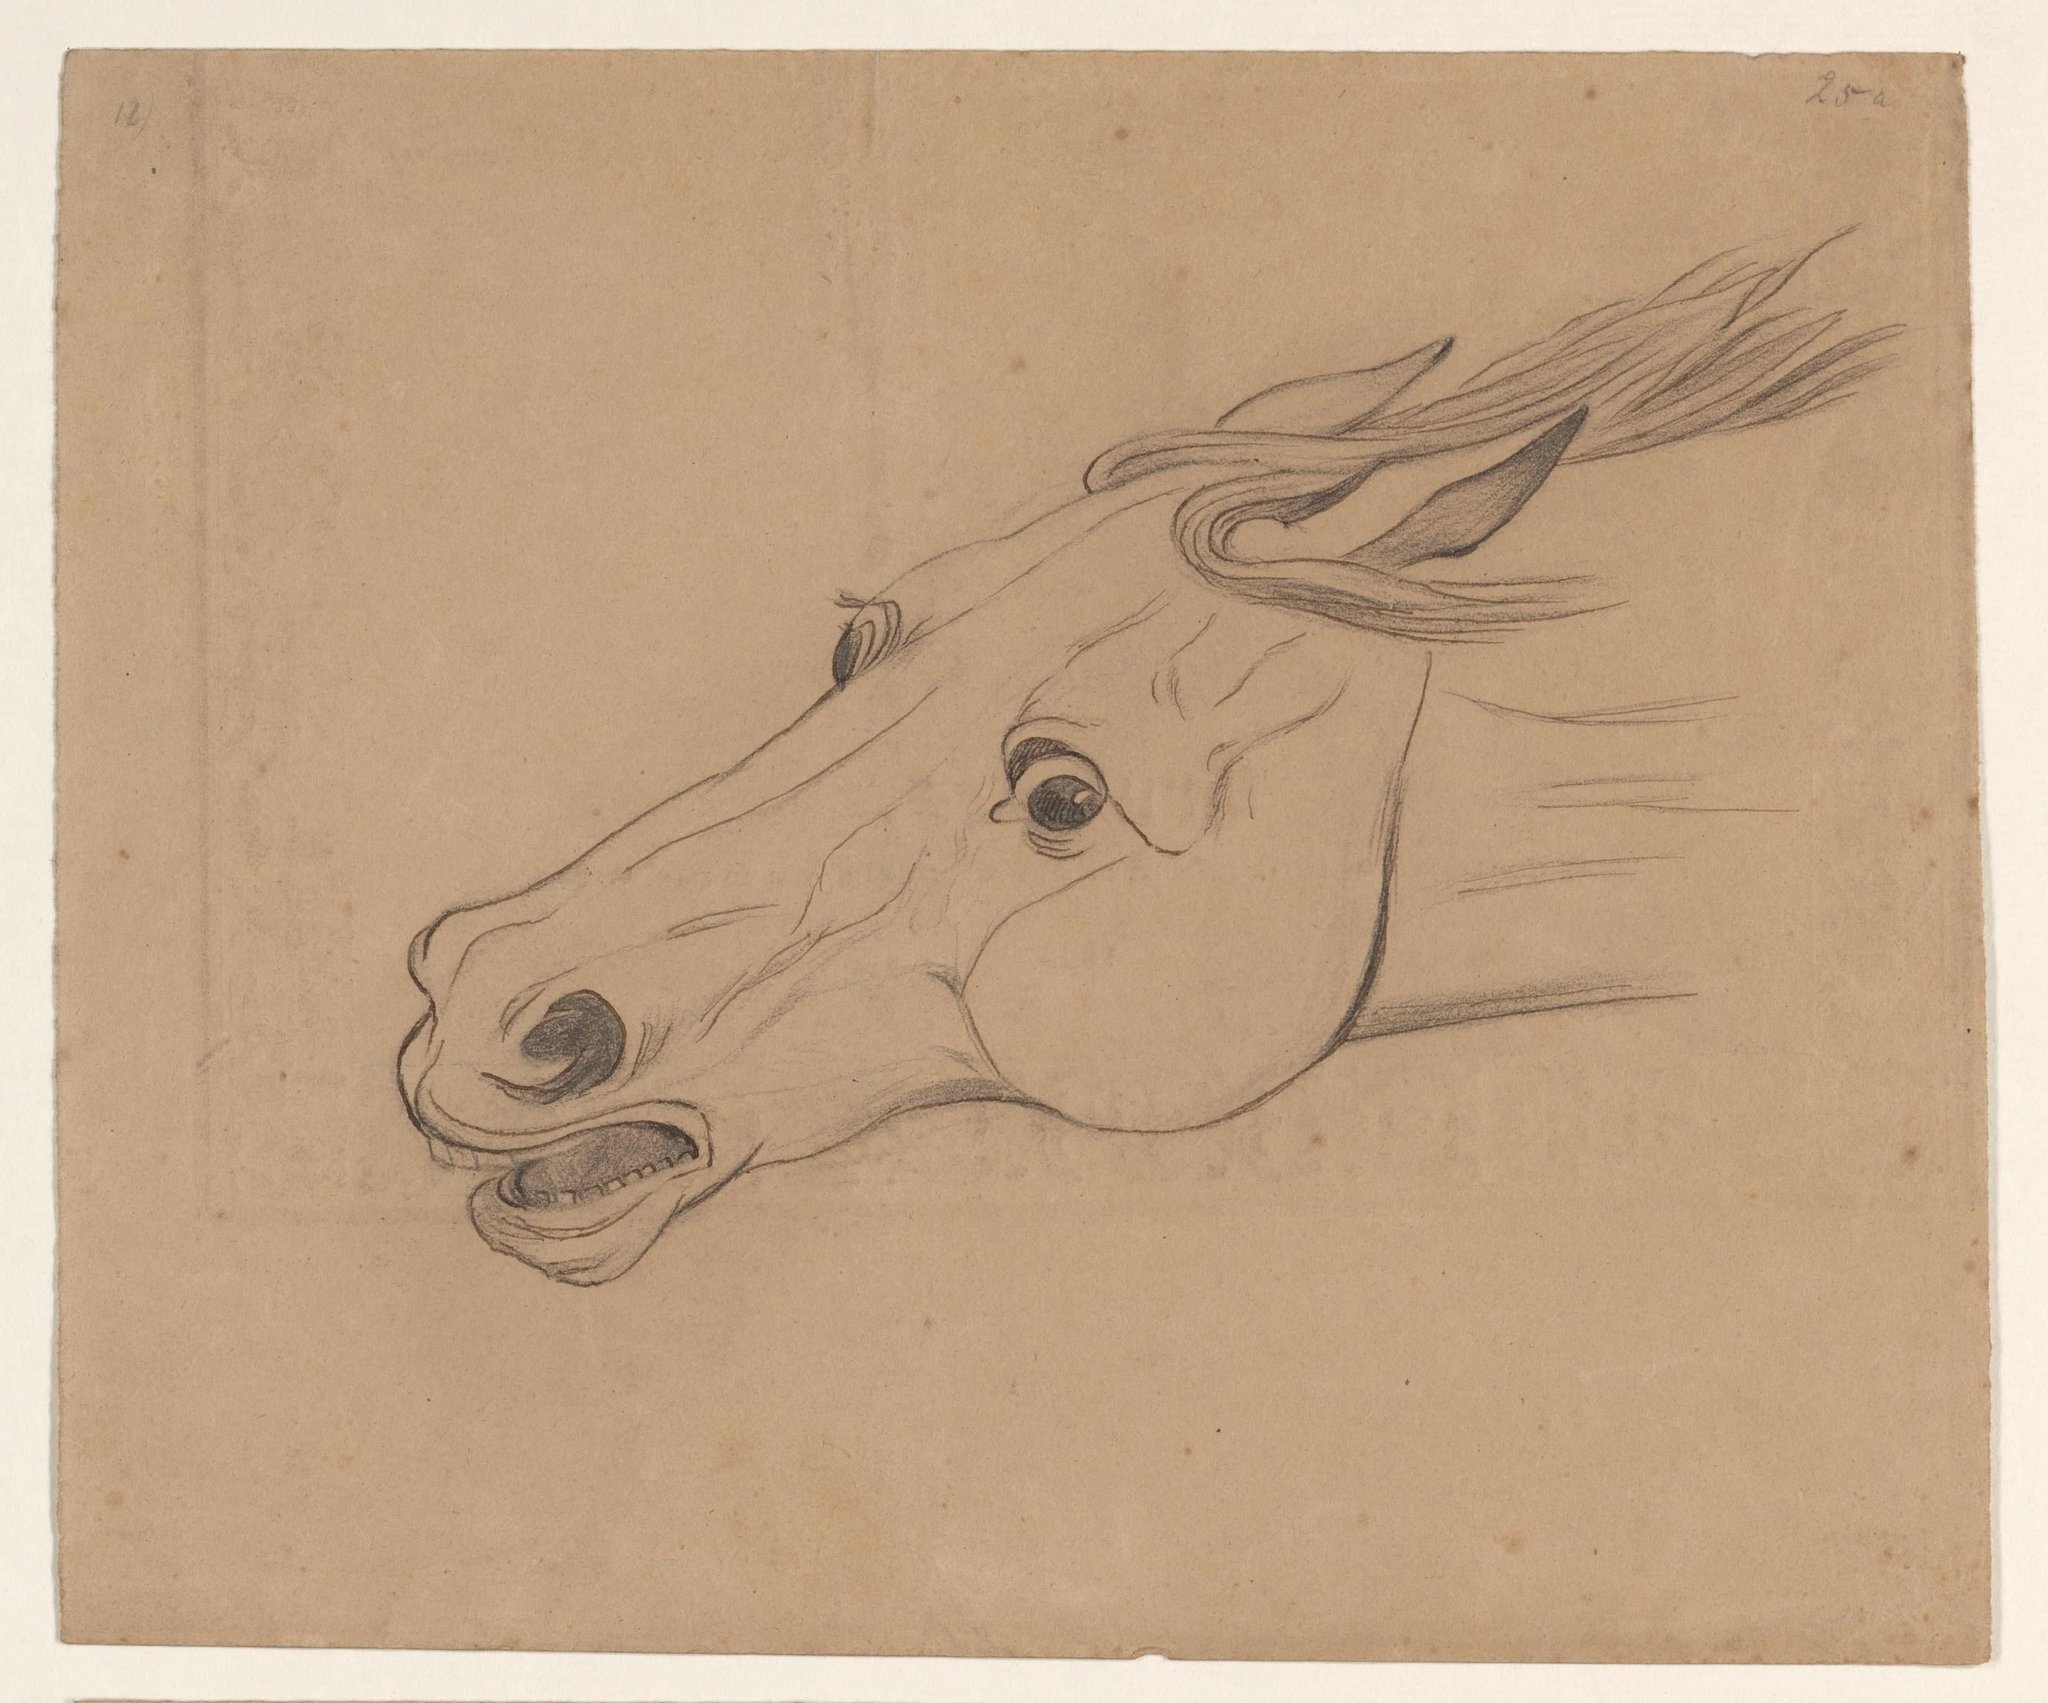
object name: drawing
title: Hoofd van een paard, naar links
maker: johannes tavenraat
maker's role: draughtsman, painter, print maker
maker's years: 1809-1881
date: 1819-1881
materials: chalk, ink, paper, pencil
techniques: pen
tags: horse